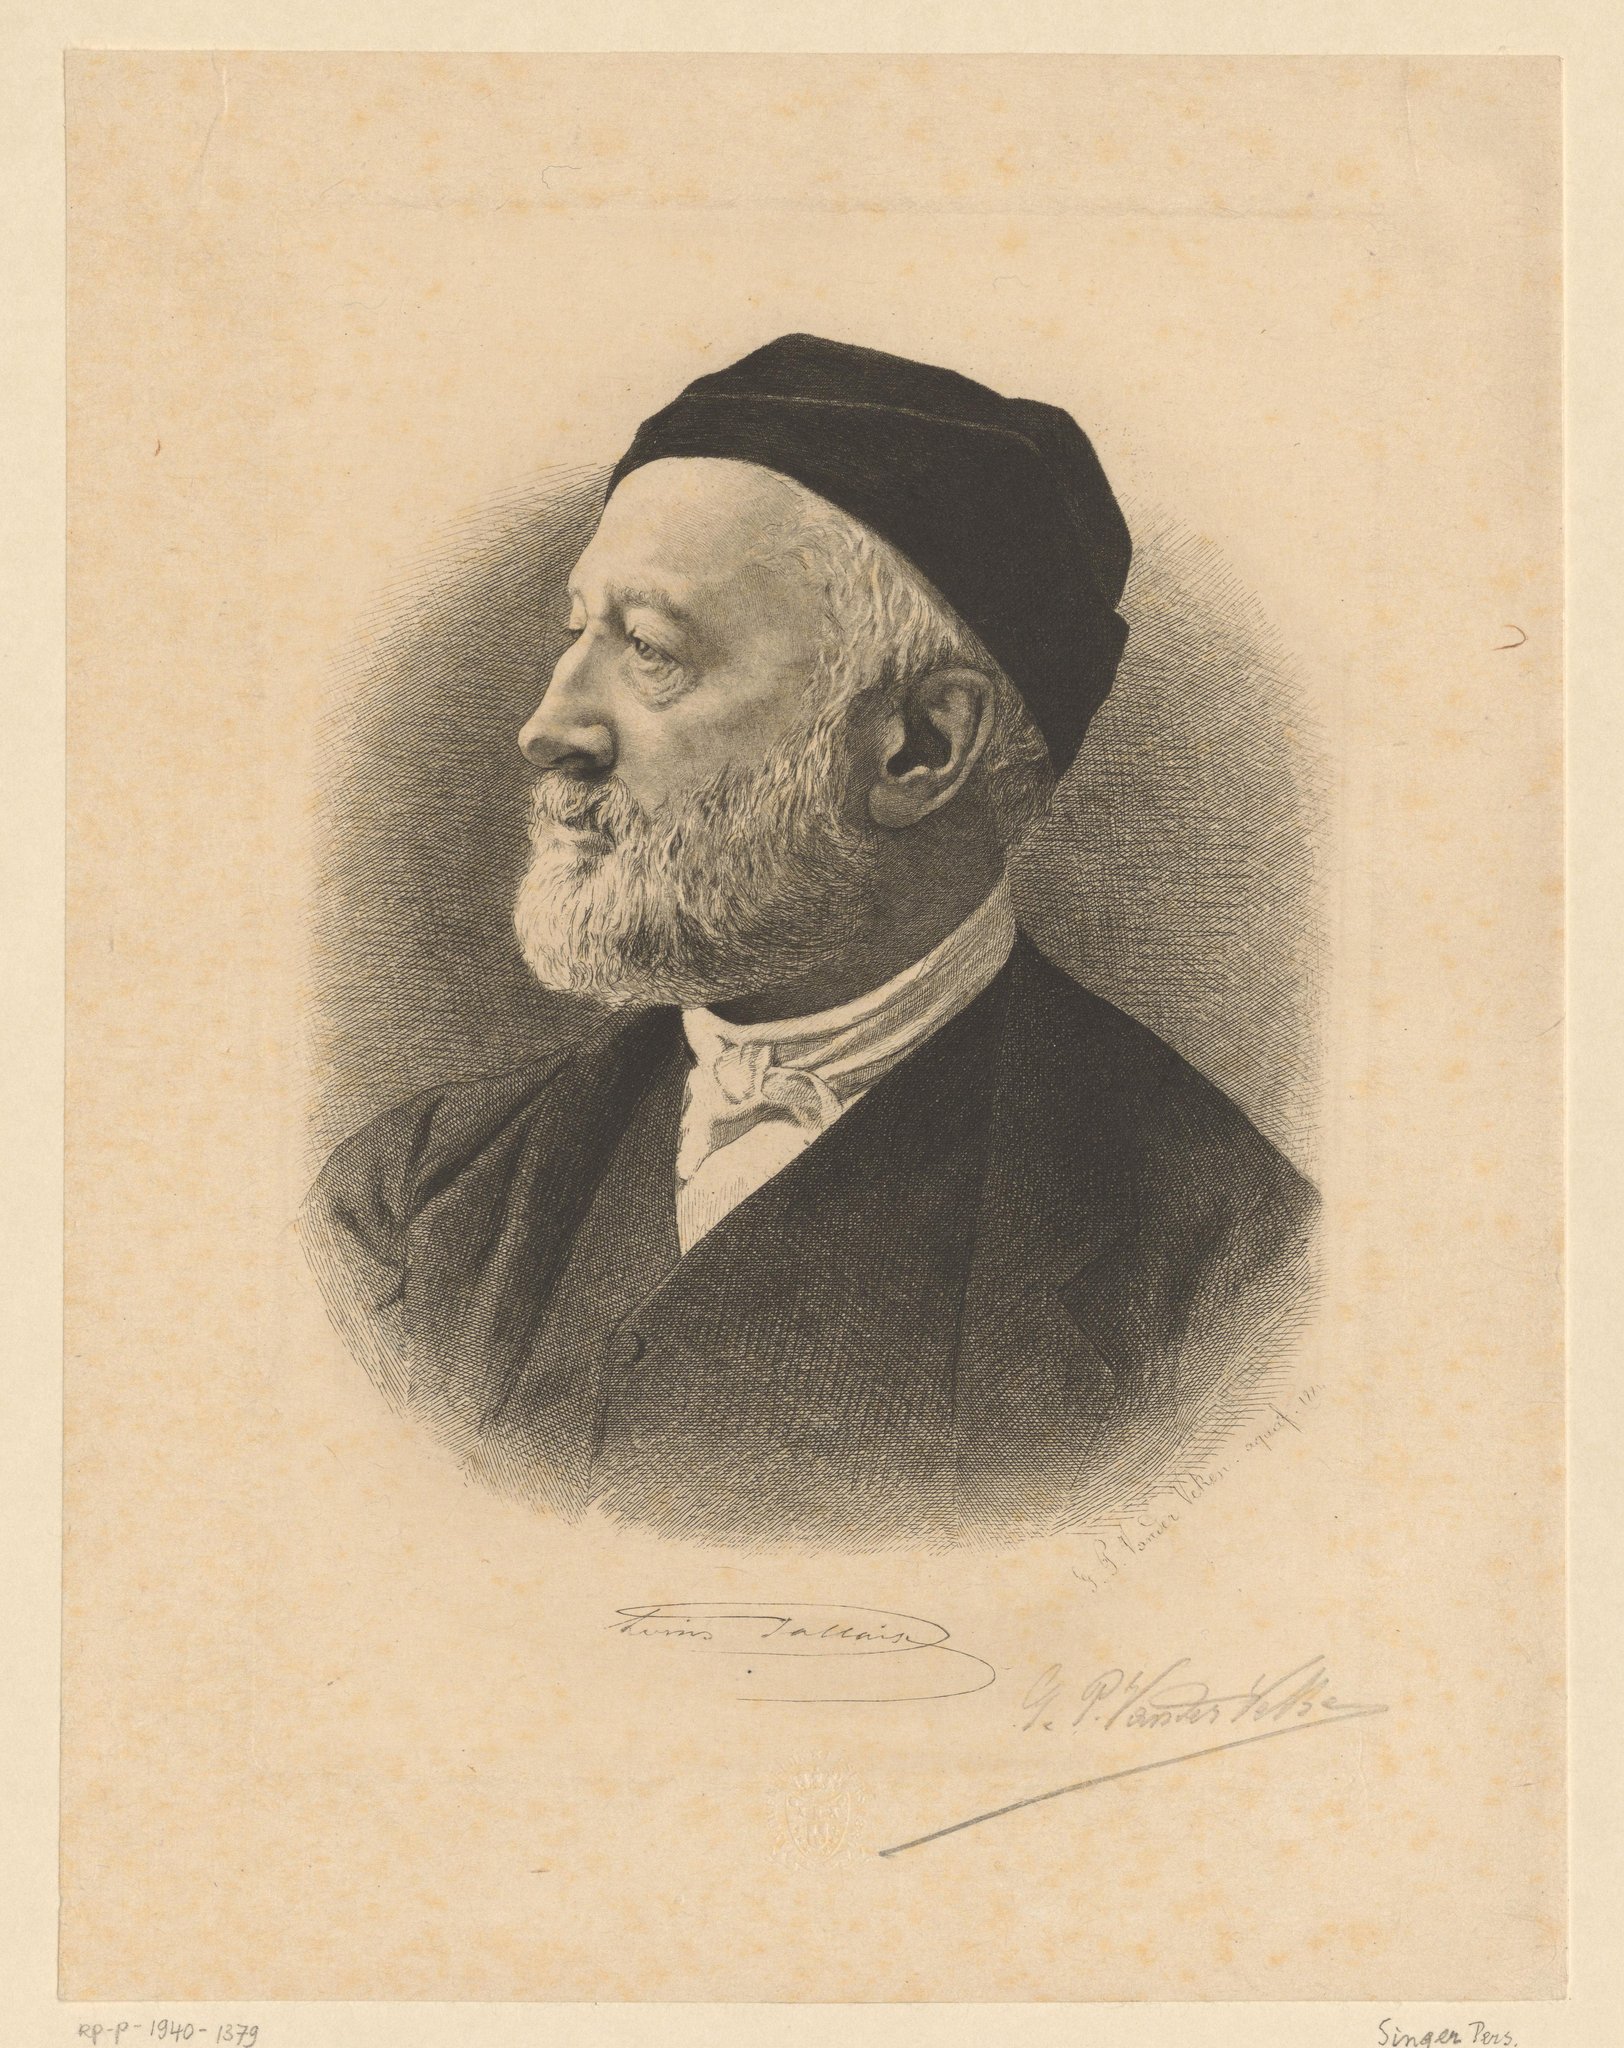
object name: print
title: Portret van Louis Gallait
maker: willem philip van der veken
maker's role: print maker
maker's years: 1863-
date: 1884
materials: paper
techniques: drypoint, etching, retroussage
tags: print maker, draughtsman, louis gallait, historical persons, portrait, self-portrait of painter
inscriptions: collector's mark: Lugt 2760, collector's mark: Lugt 2166